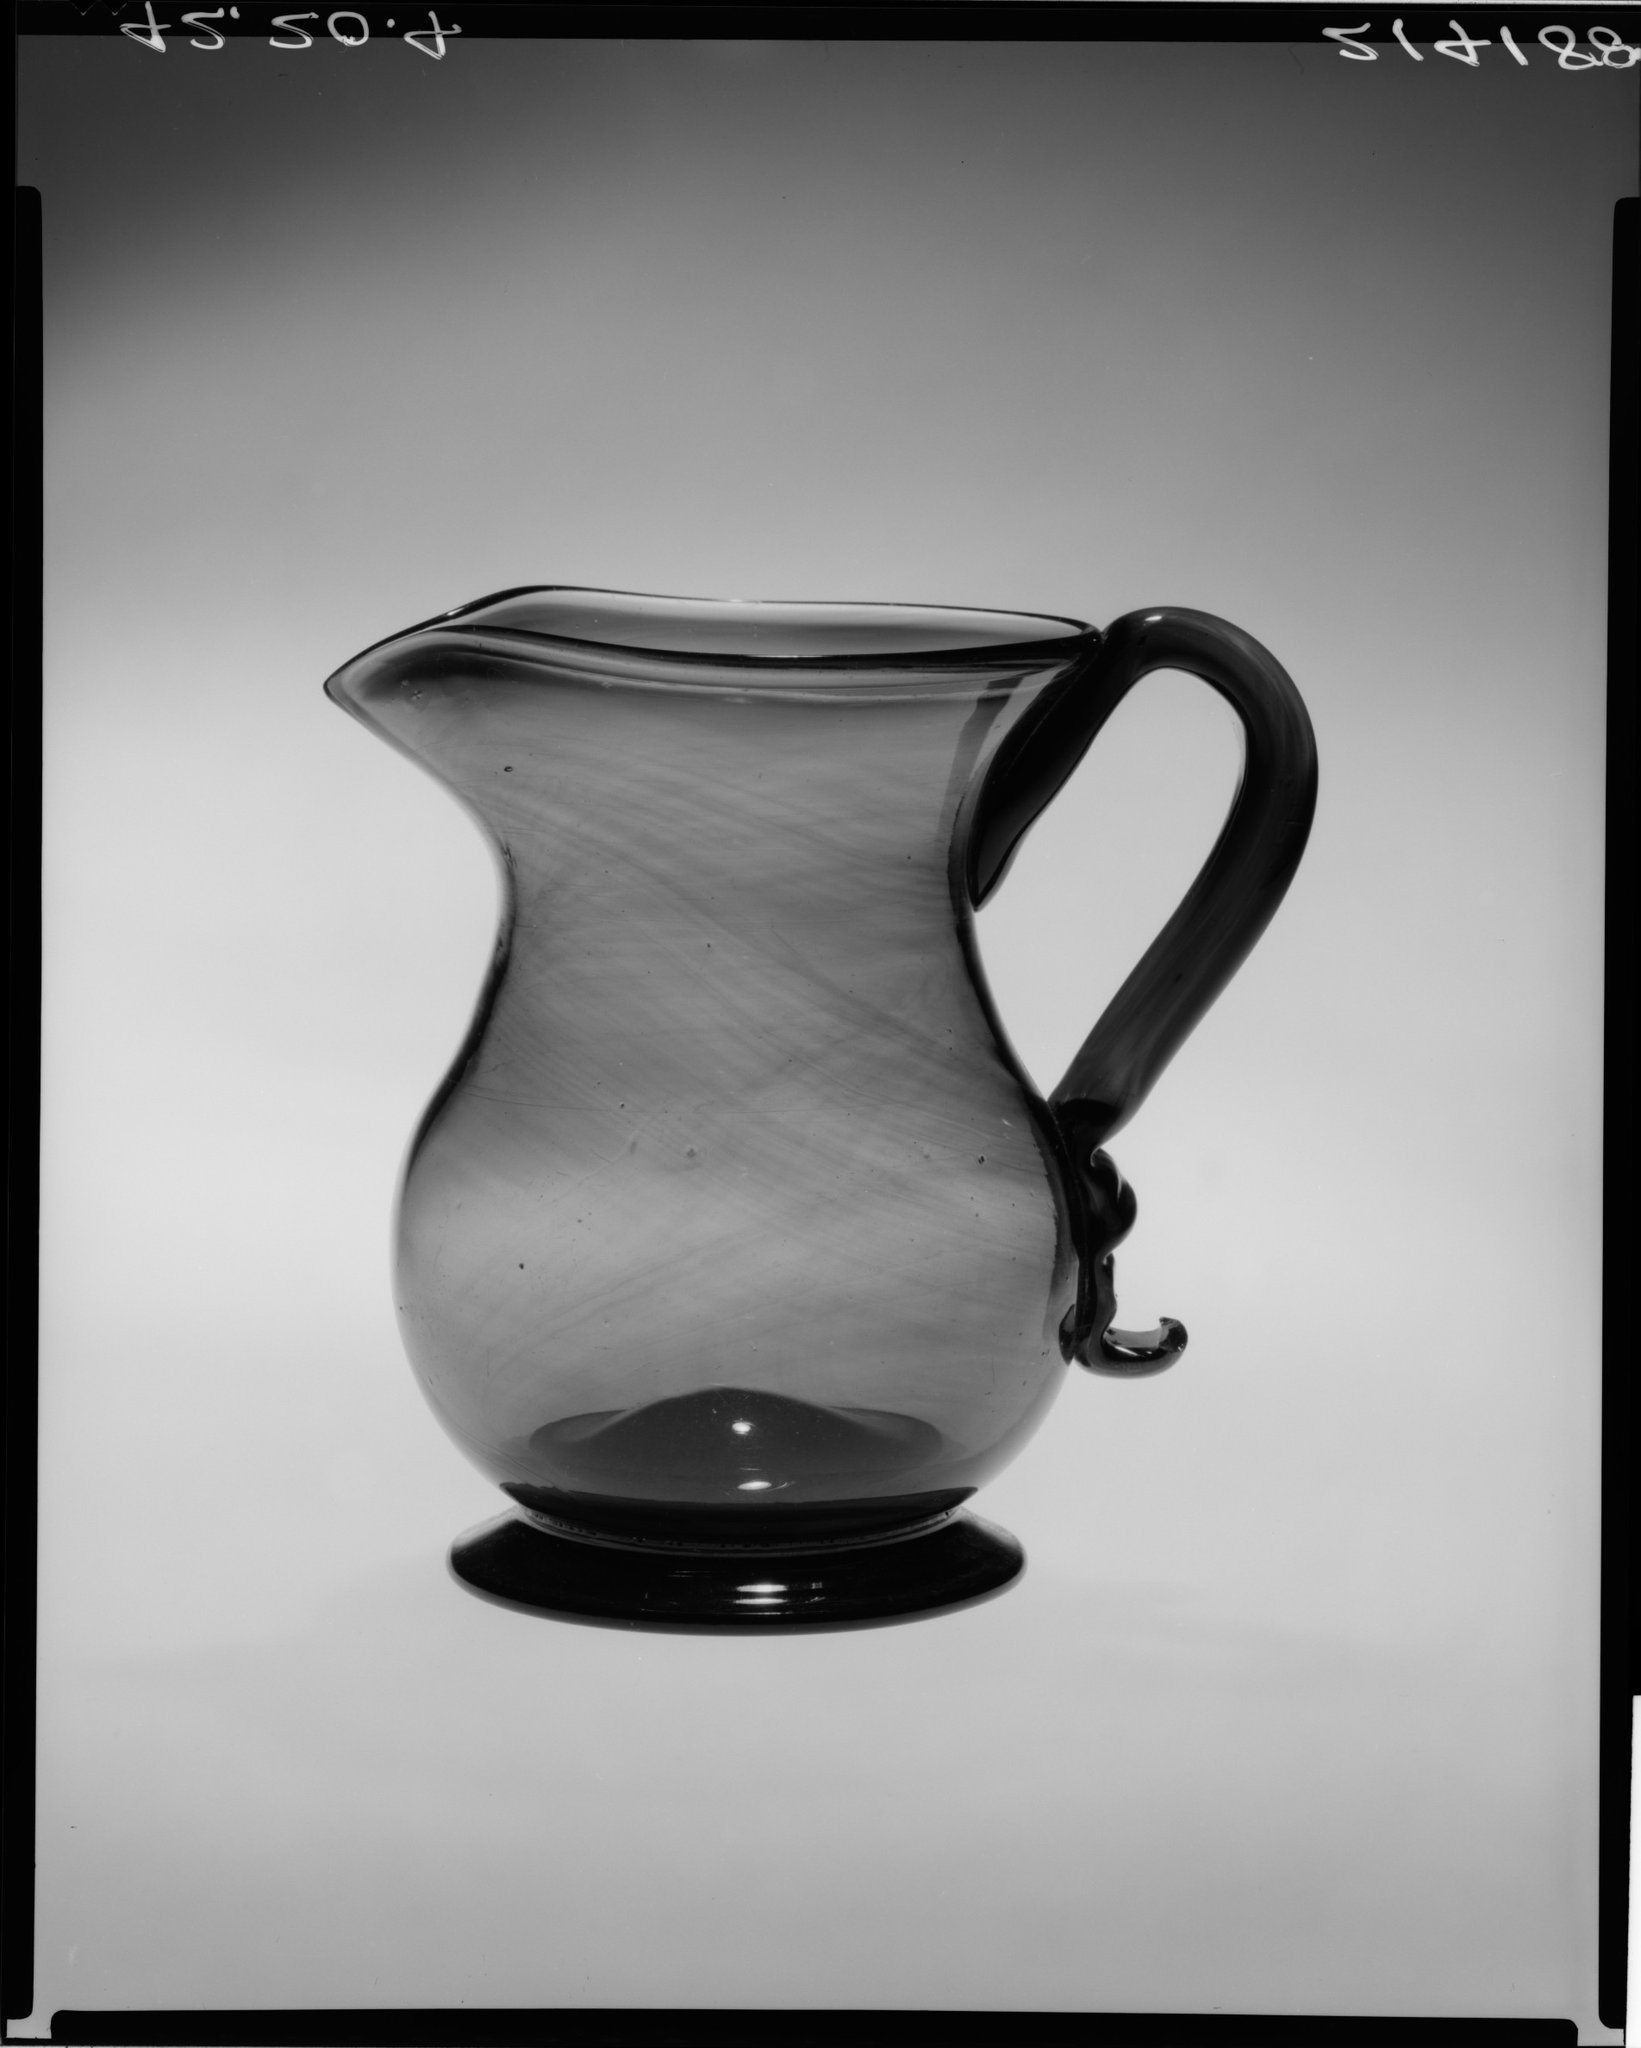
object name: cream pot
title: Creamer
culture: american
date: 1800-1850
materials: gemstone, glass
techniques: glassblowing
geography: united states